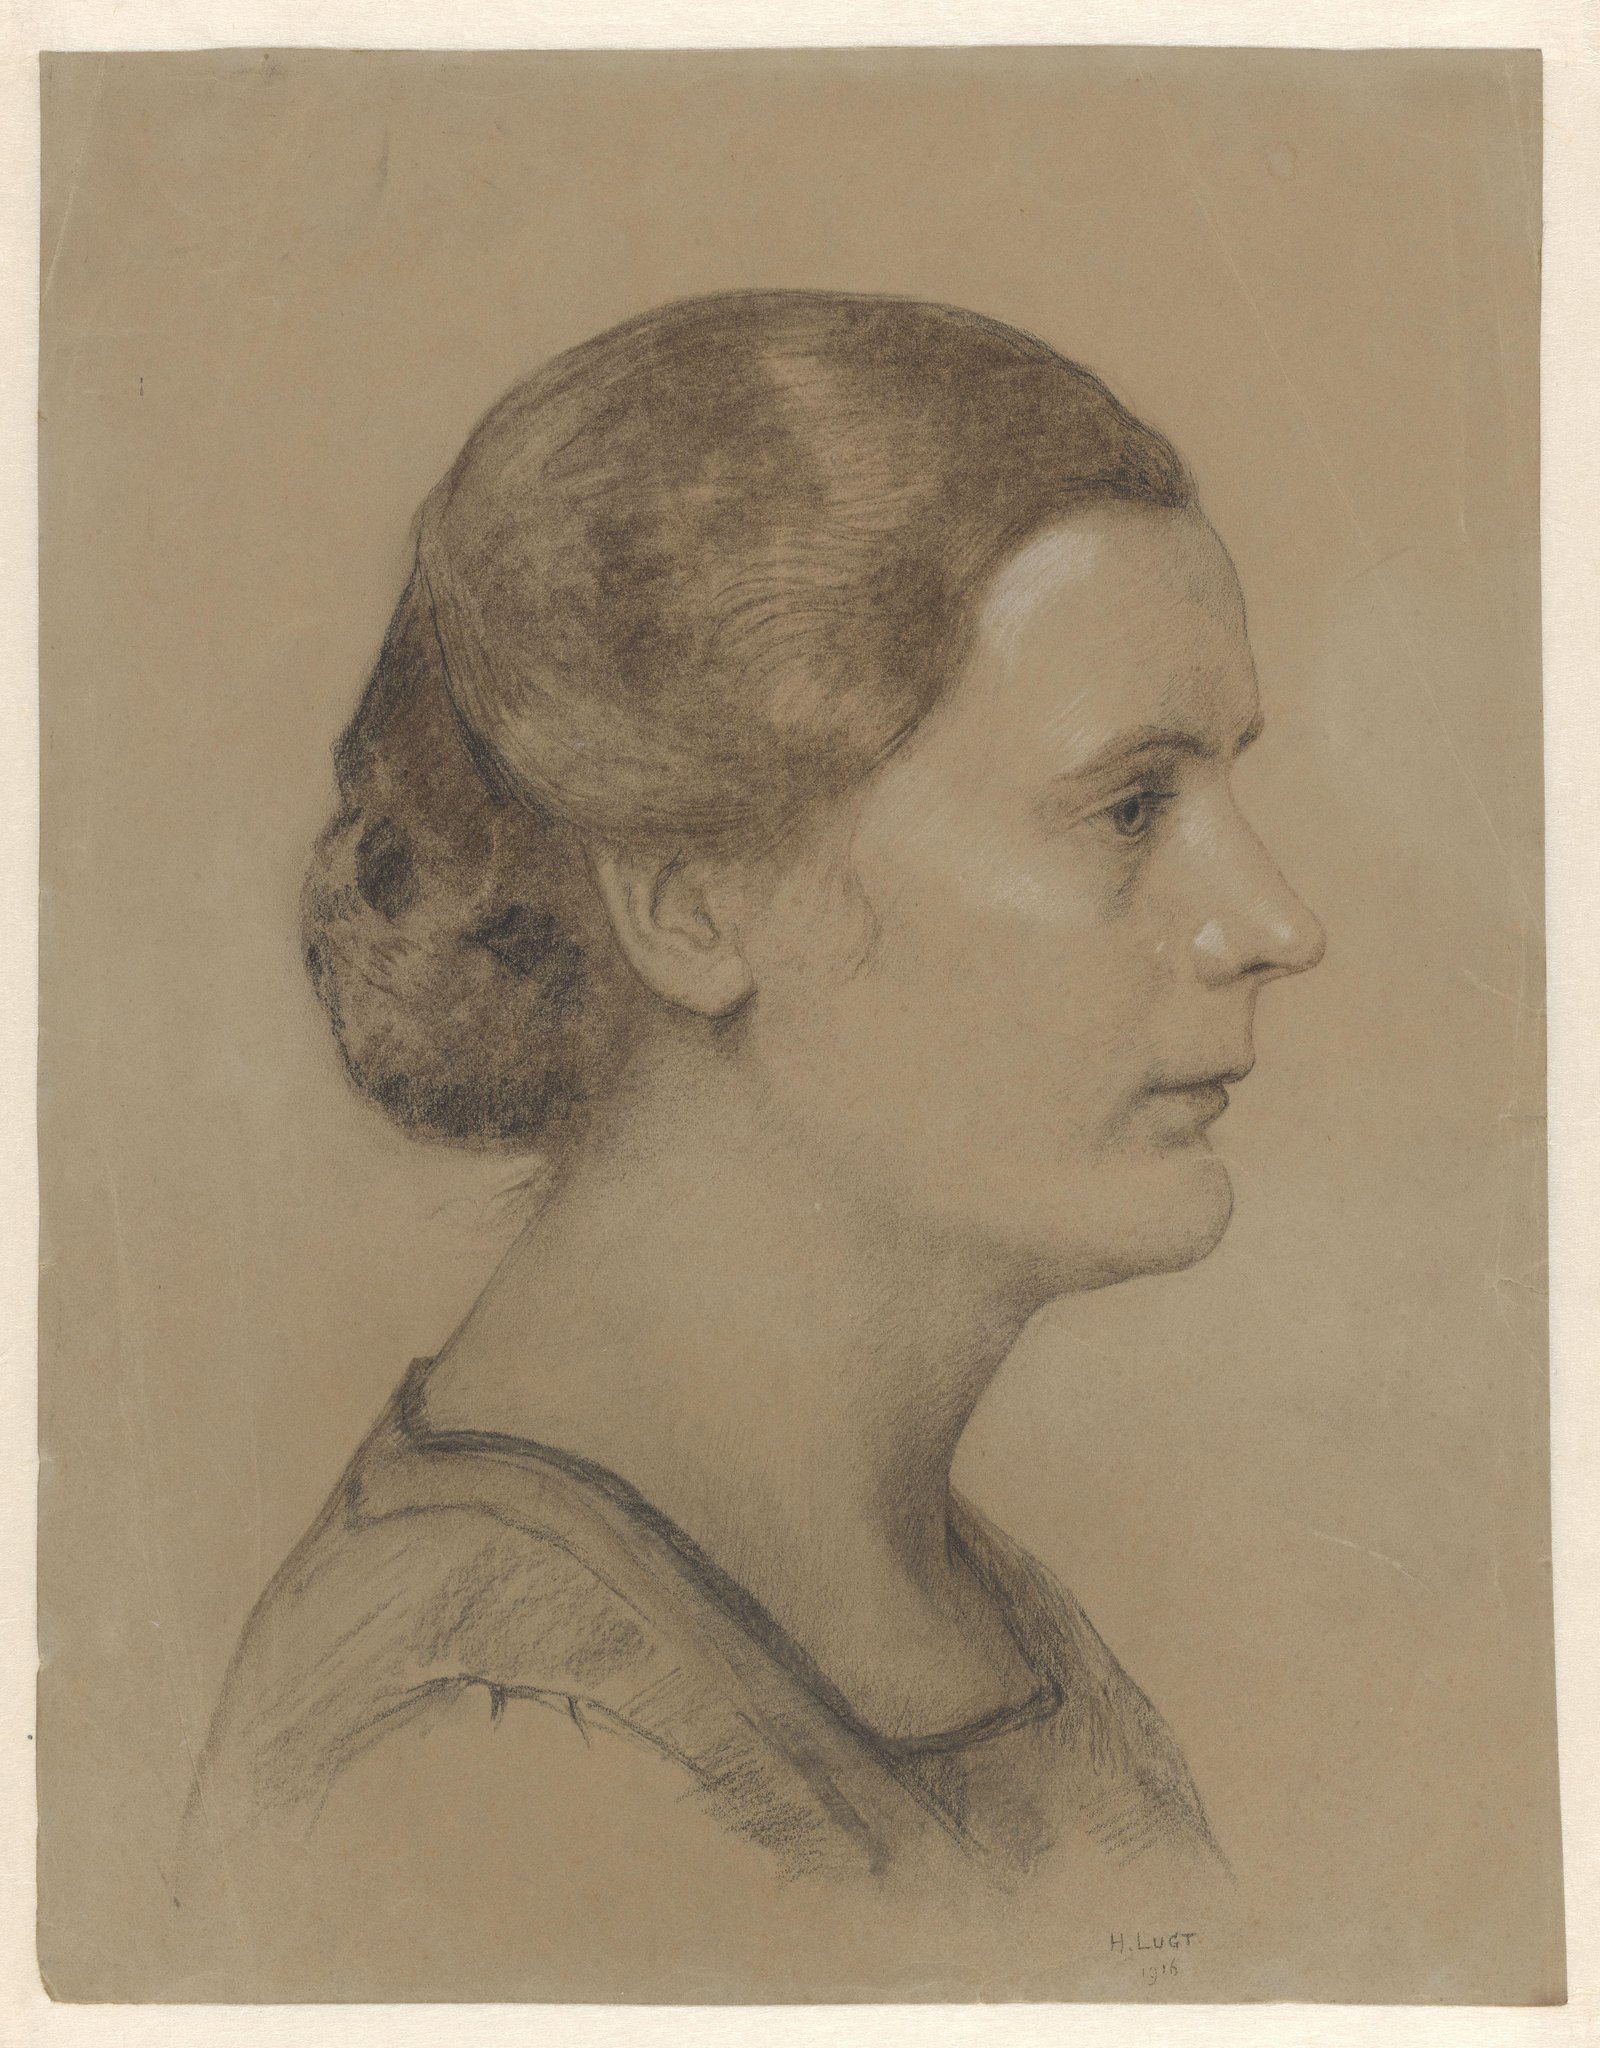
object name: drawing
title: Portret van een onbekende vrouw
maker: herman lugt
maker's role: draughtsman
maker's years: 1881-1950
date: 1916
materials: chalk, charcoal, paper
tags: anonymous historical person portrayed alone